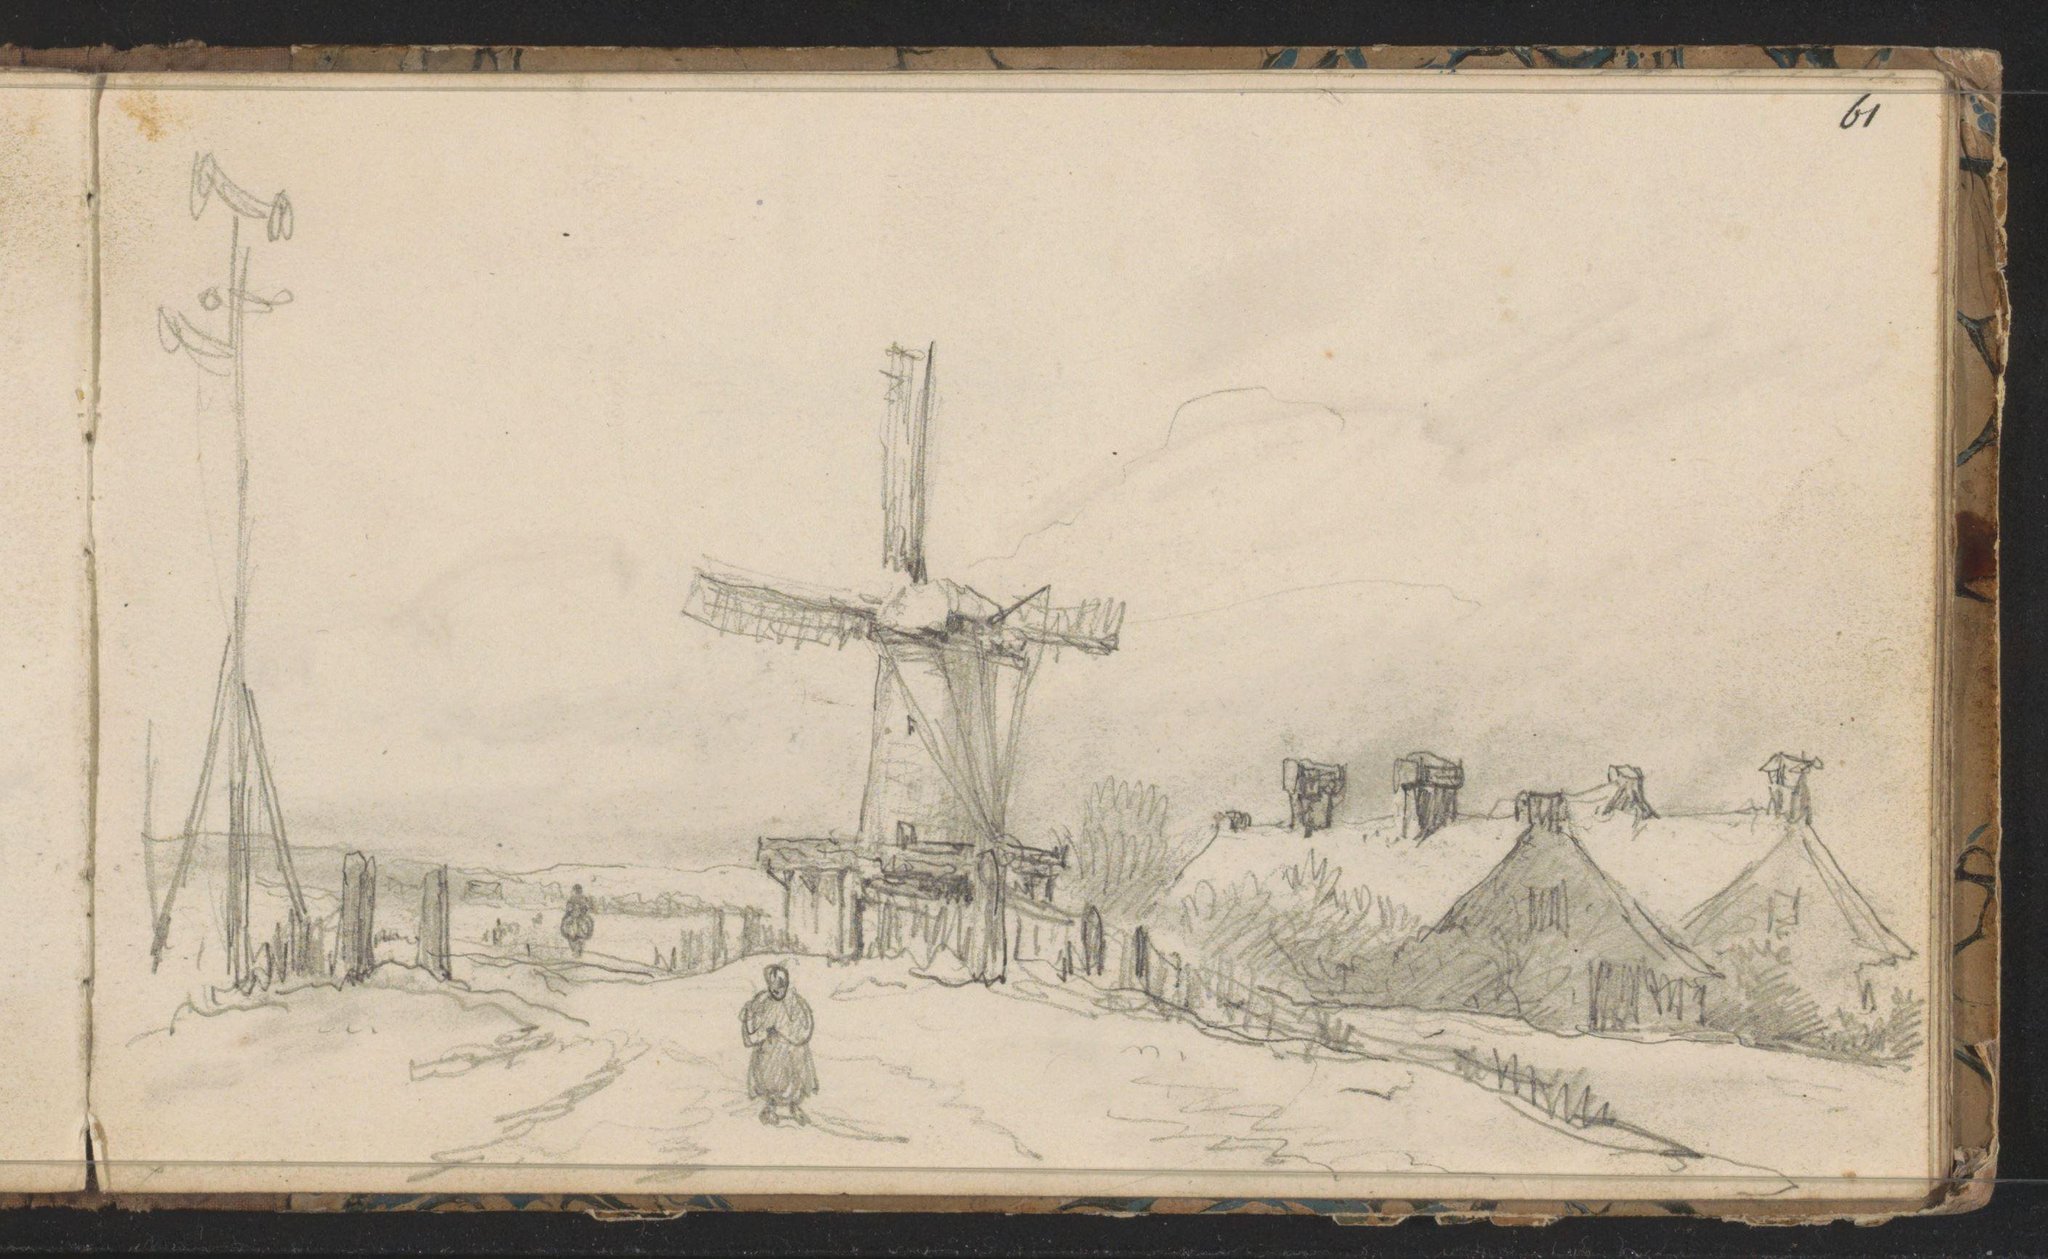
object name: sketchbook leaf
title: Figuren op een dorpspad met een molen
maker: arnoldus johannes eymer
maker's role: draughtsman, print maker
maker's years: 1803-1863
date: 1803-1818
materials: paper, pencil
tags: windmill in landscape, village street (+ city(-scape) with figures, staffage)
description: Bladzijde 61 uit een schetsboek met 74 bladzijden.